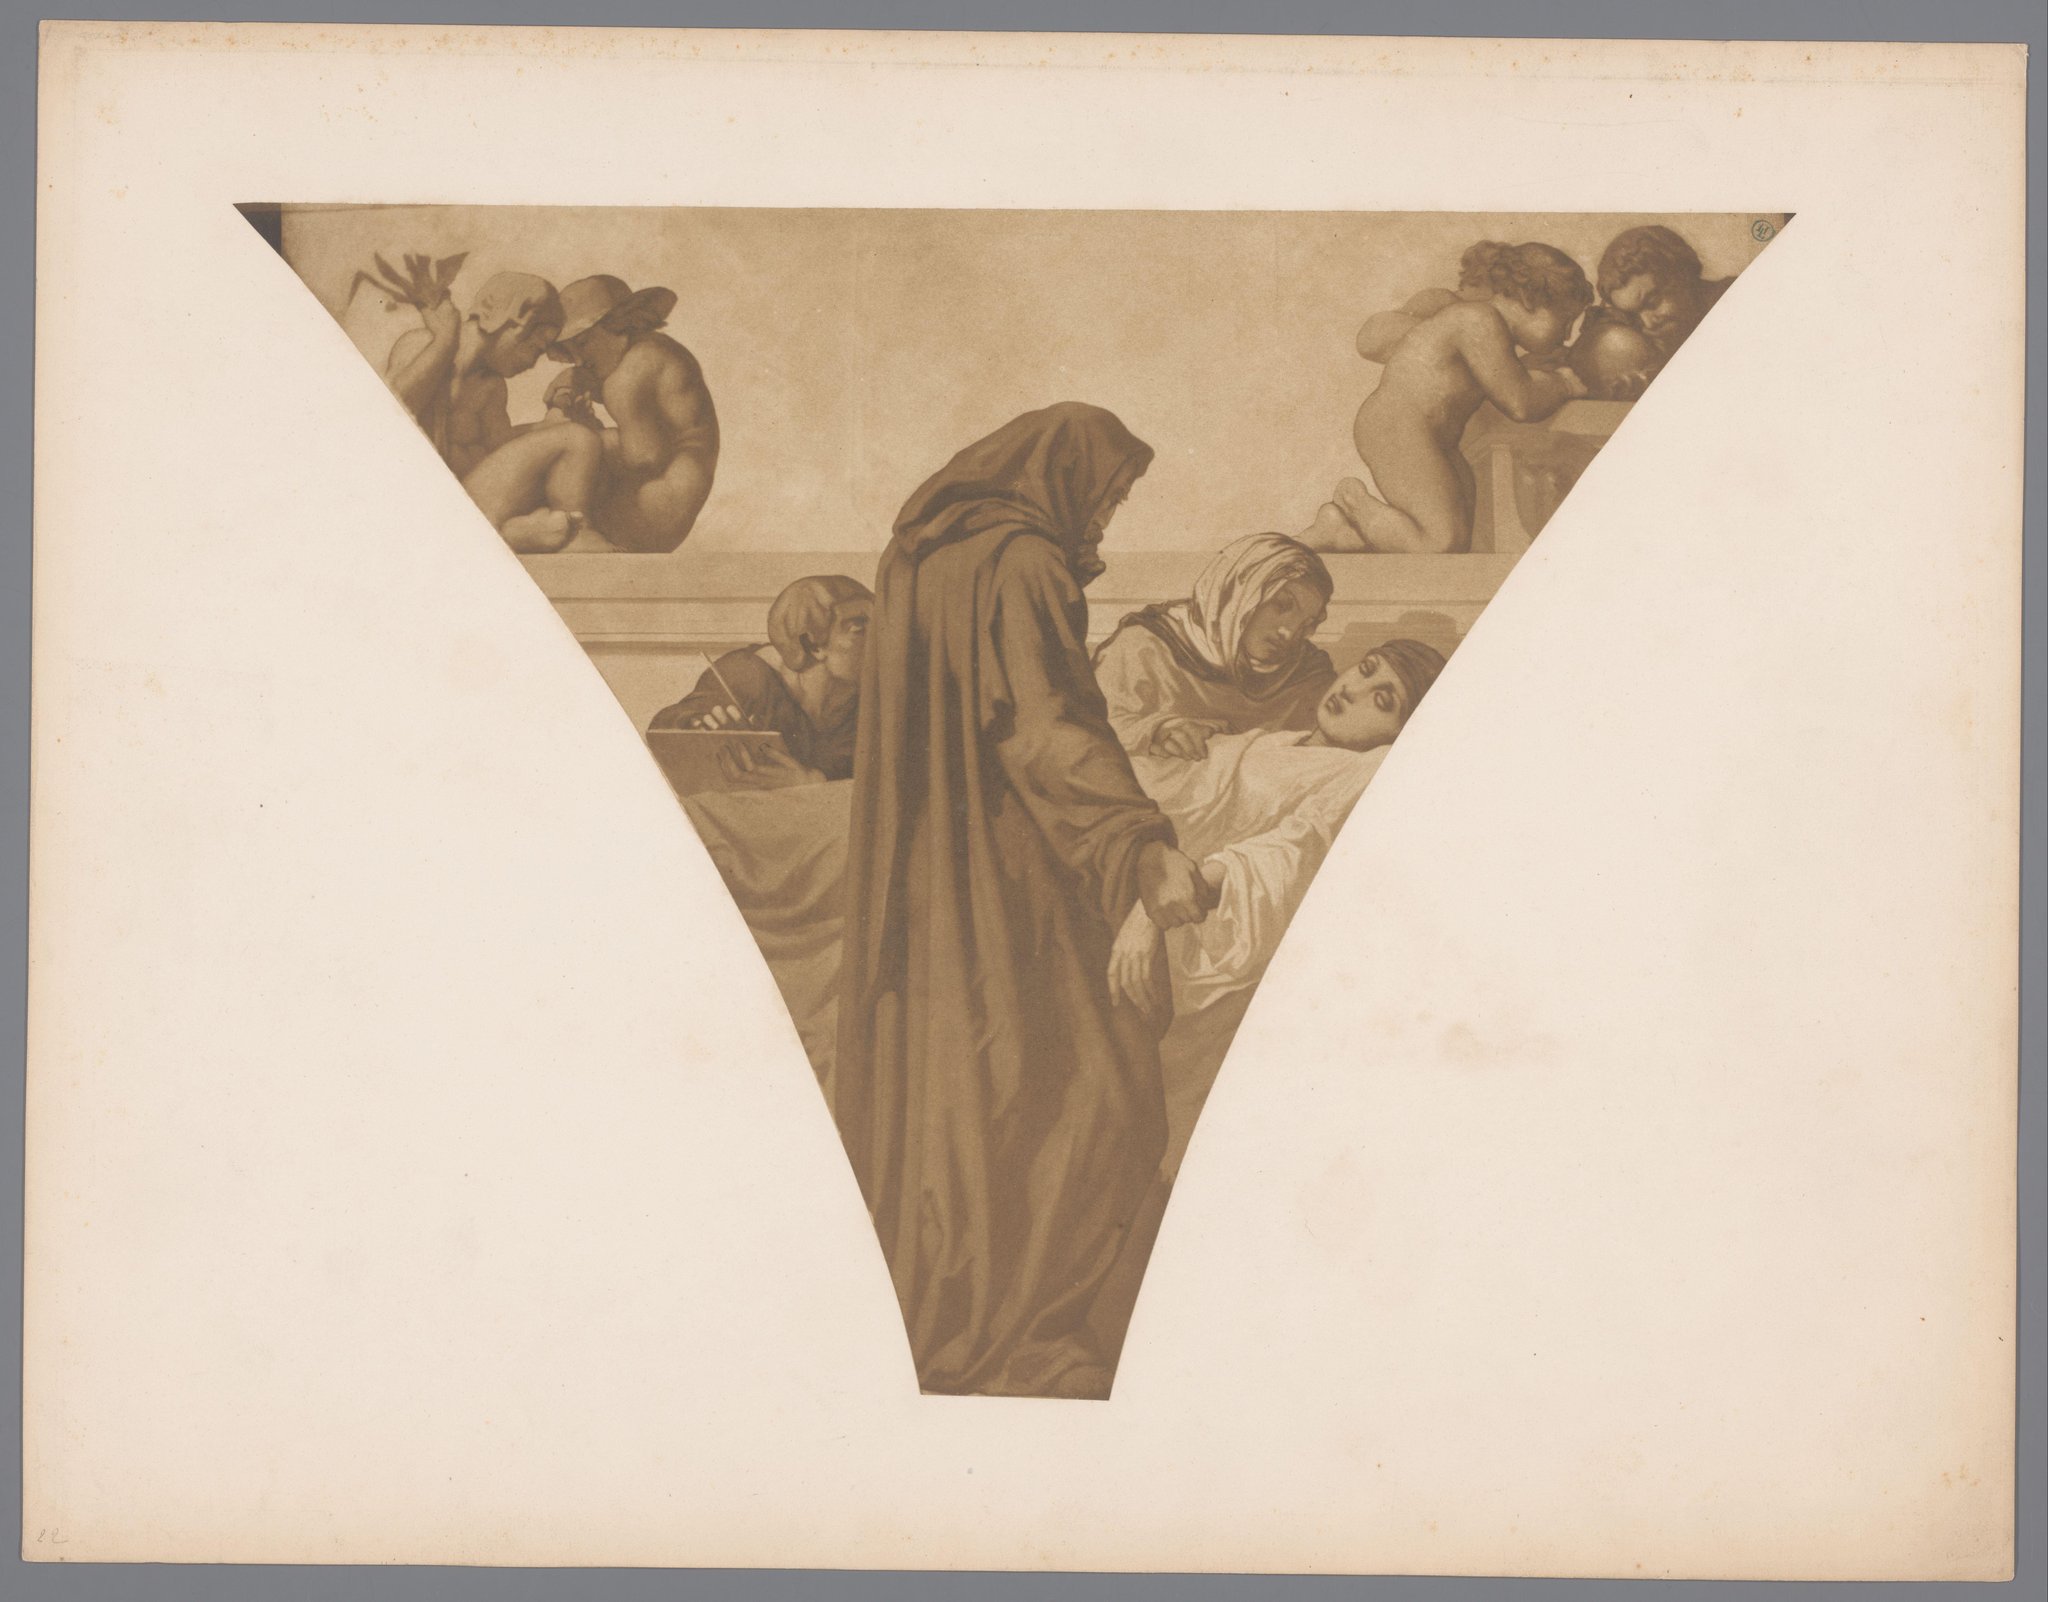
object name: photograph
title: Fotografische reproductie van decoratie aan plafond, Hotel de Ville, Parijs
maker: gustave le gray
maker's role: fotograaf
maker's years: 1820-1884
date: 1852-1853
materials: cardboard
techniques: salted paper print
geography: paris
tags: paris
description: Maakt onderdeel uit van een serie van 18 bladen met foto's van de cartons voor de plafondschilderingen door Henri Lehmann voor de Galerie des Fêtes in het Hotel de Ville, Parijs.